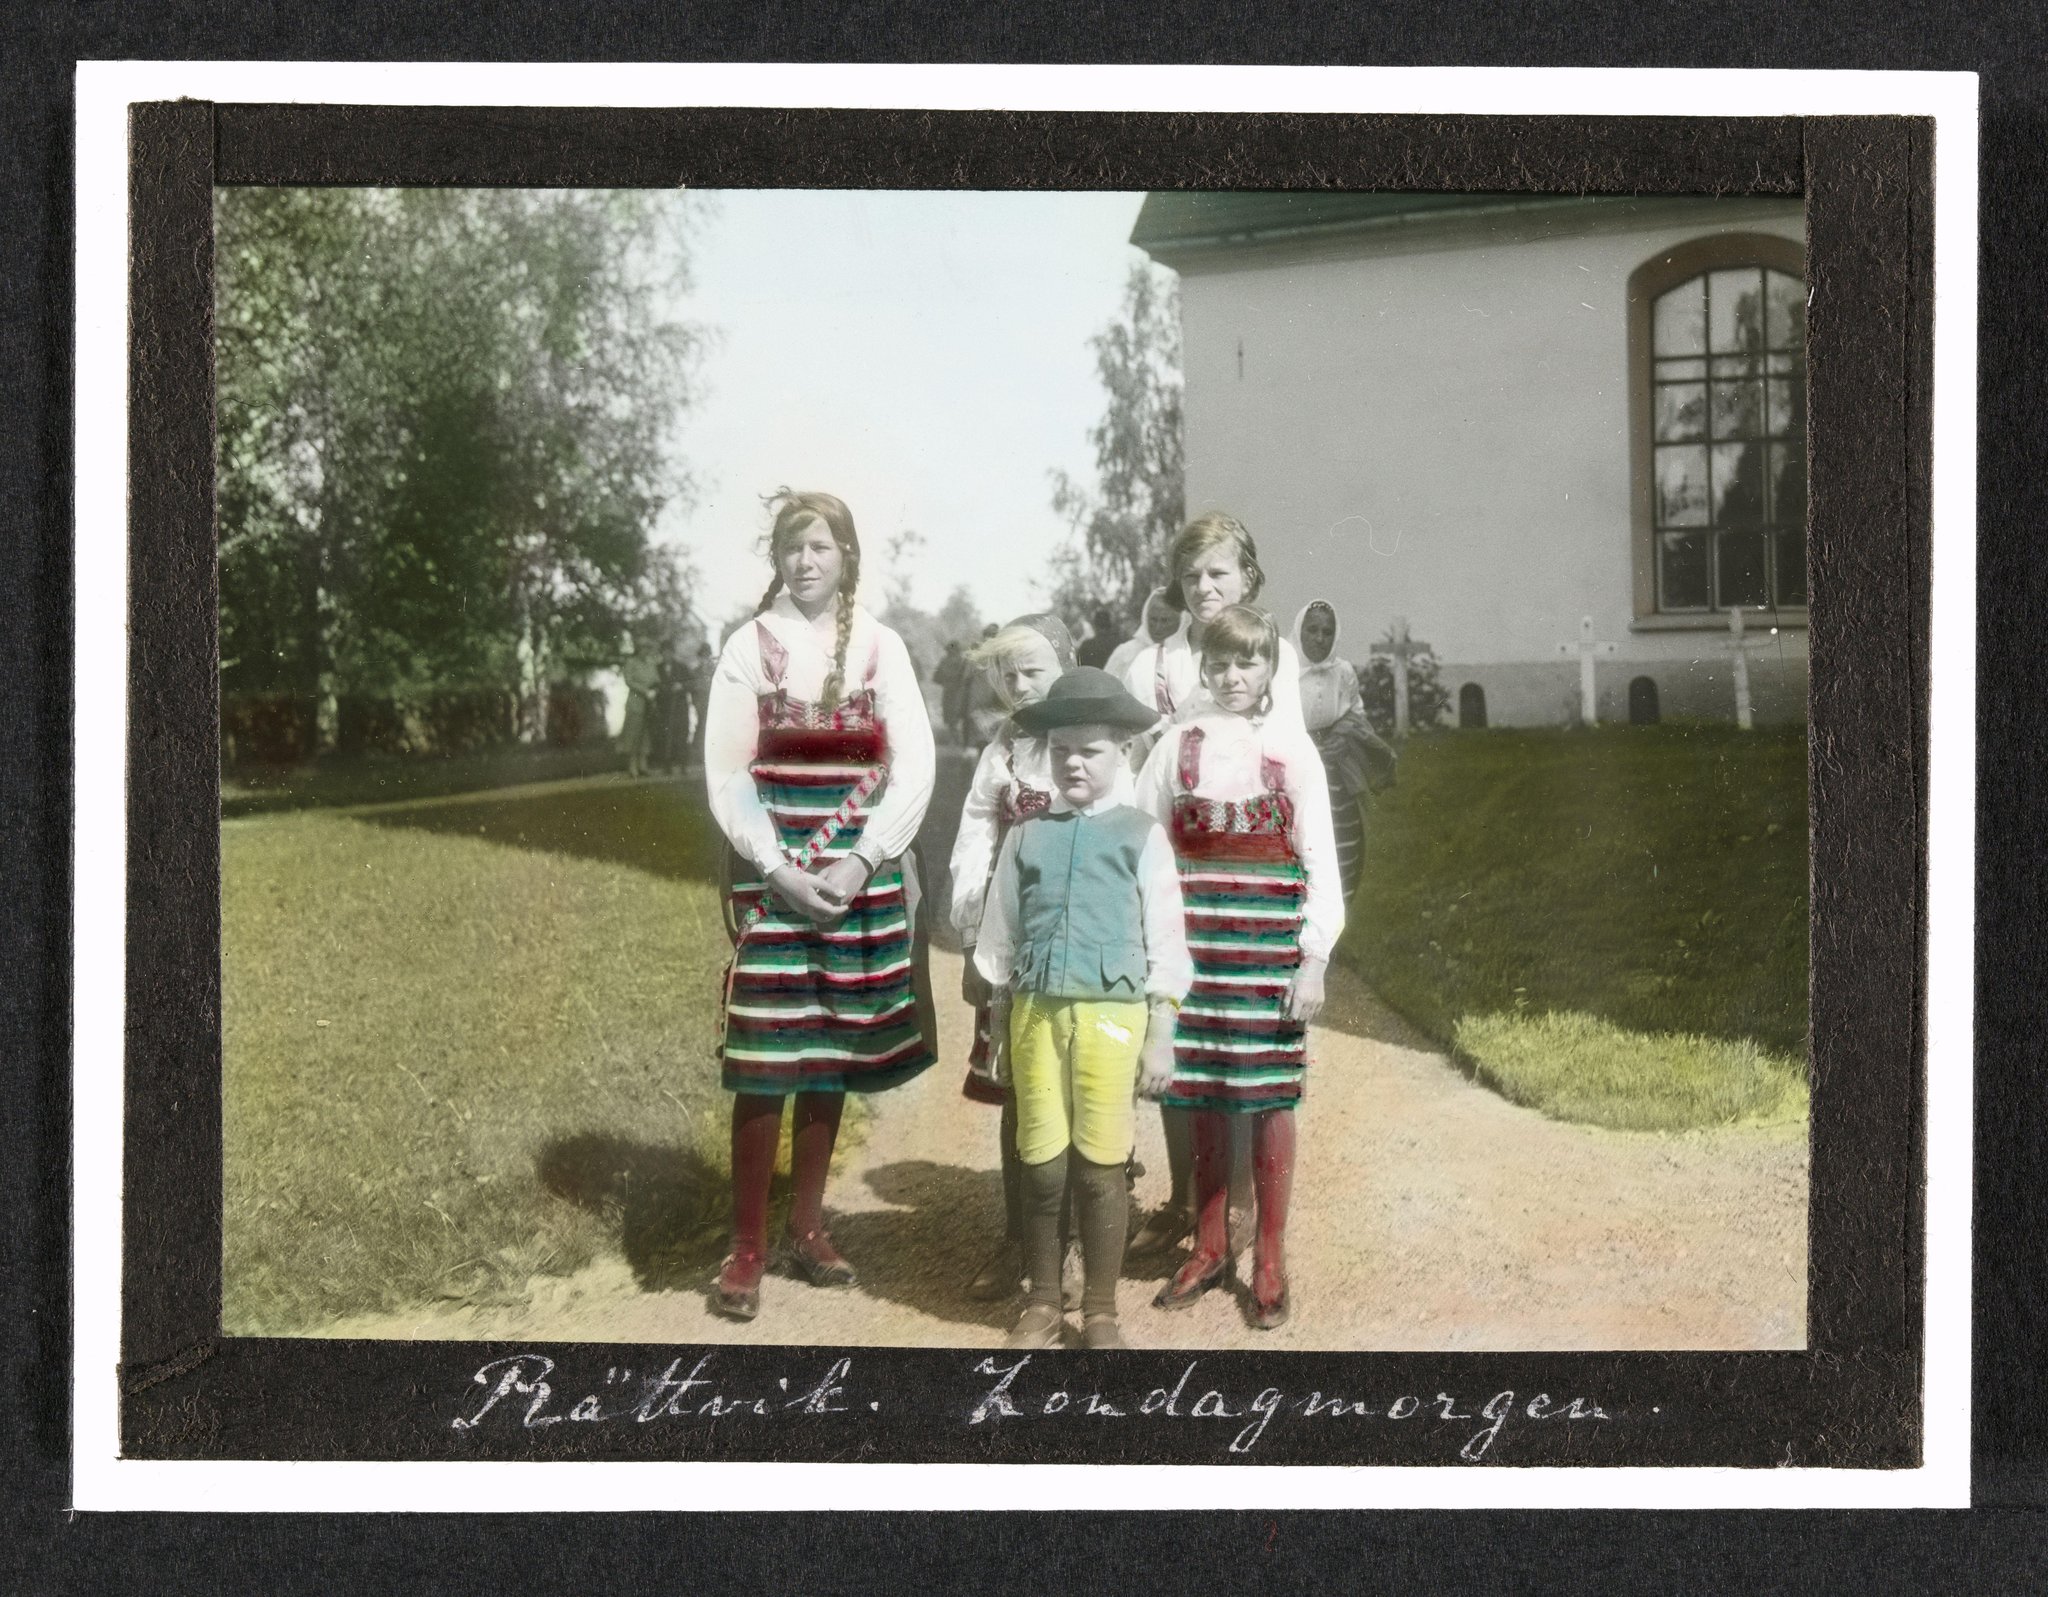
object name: glasdia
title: Rättvik. Zondagmorgen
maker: Anonymous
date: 1907-1935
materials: glass, ink, paper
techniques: gelatin silver transparency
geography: rättvik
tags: child, church (exterior), anonymous historical persons portrayed in a group, in a group-portrait